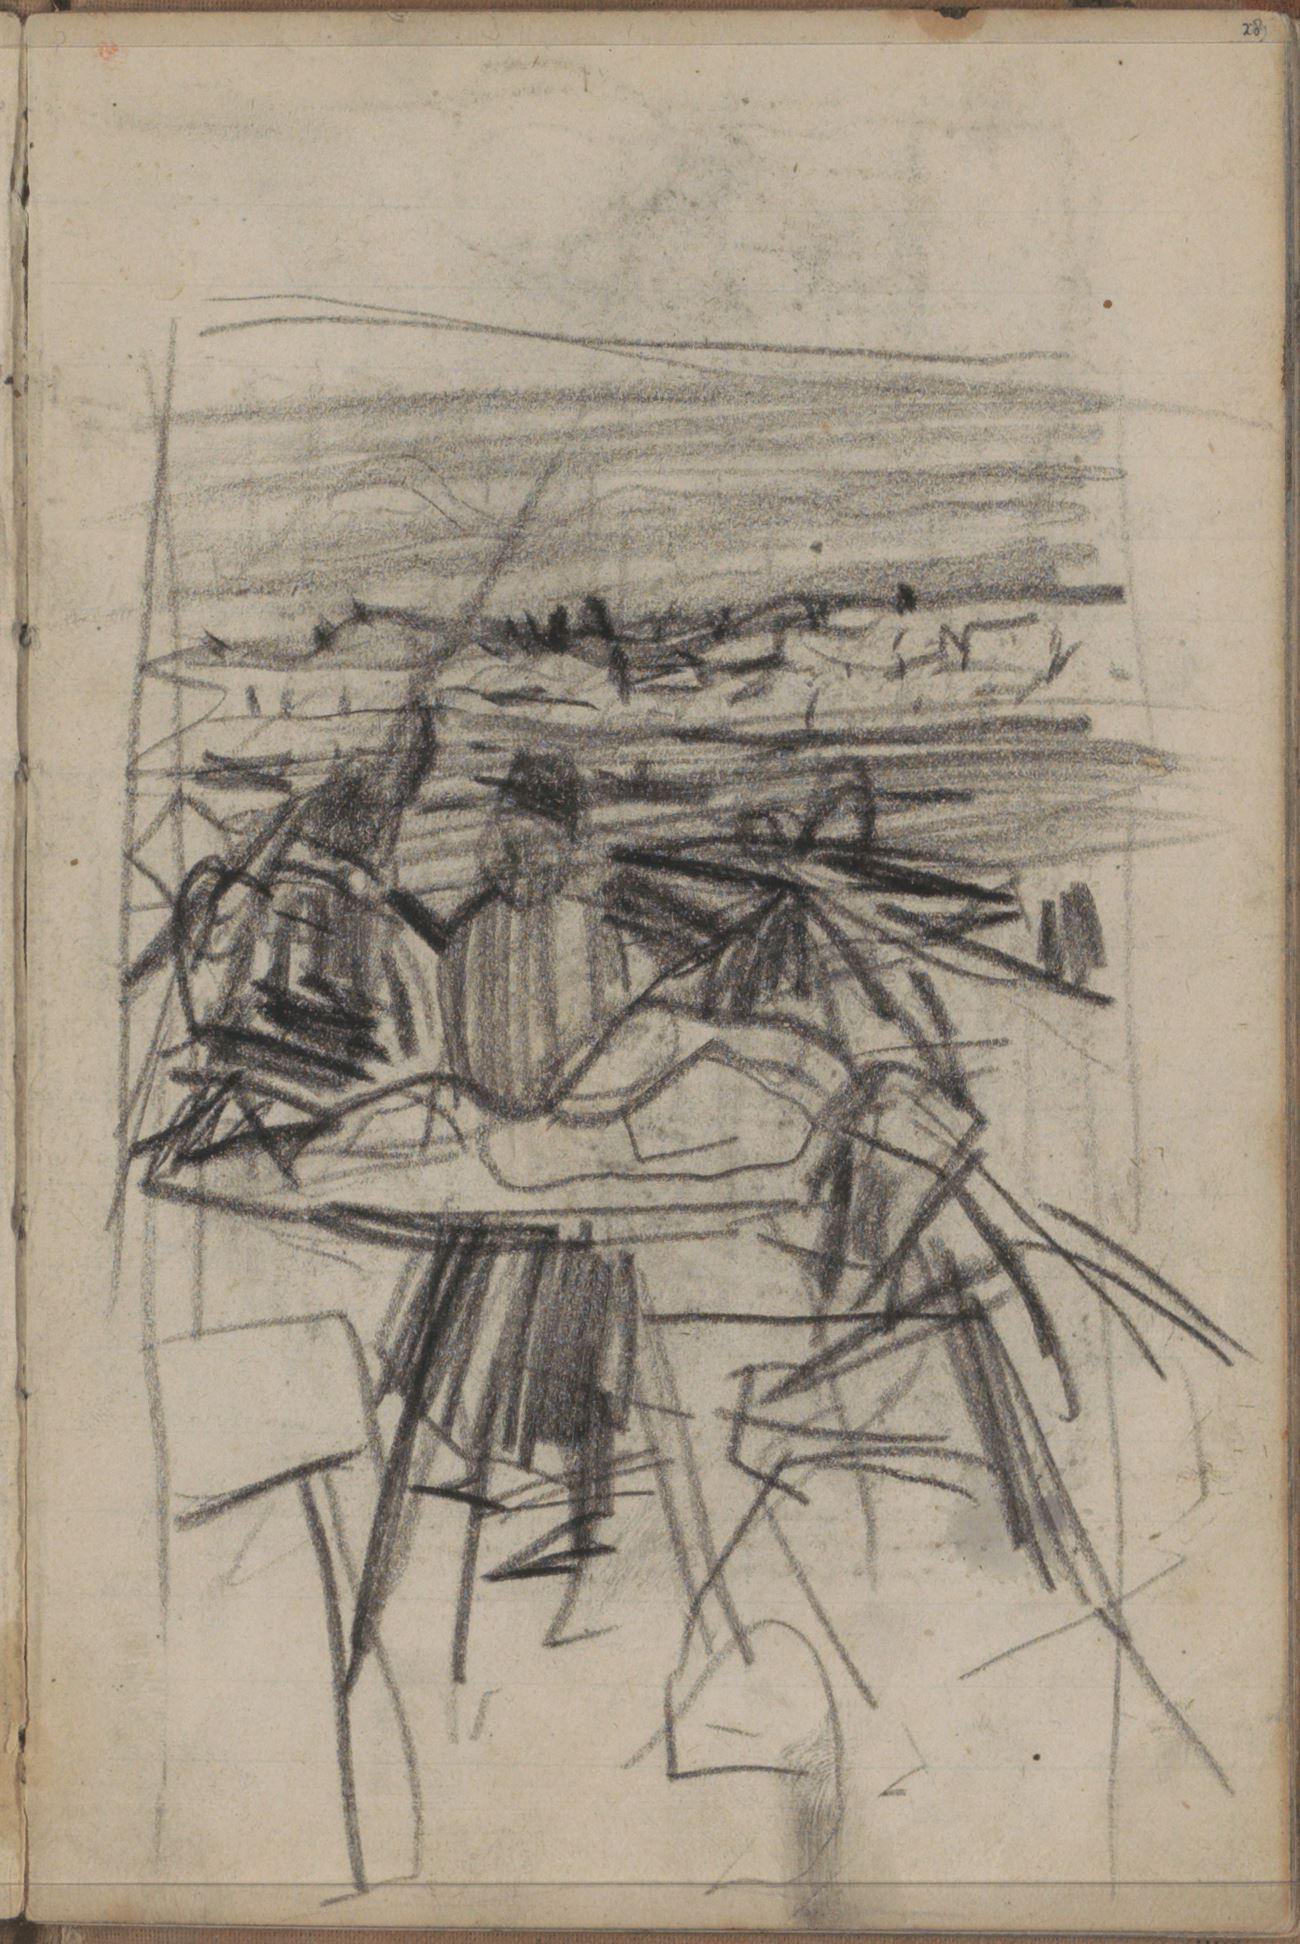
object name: sketchbook leaf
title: Landschap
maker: marius bauer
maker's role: draughtsman, print maker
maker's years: 1867-1932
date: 1888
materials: chalk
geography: istanbul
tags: landscapes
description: Pagina 28 uit een schetsboek met 58 bladen.